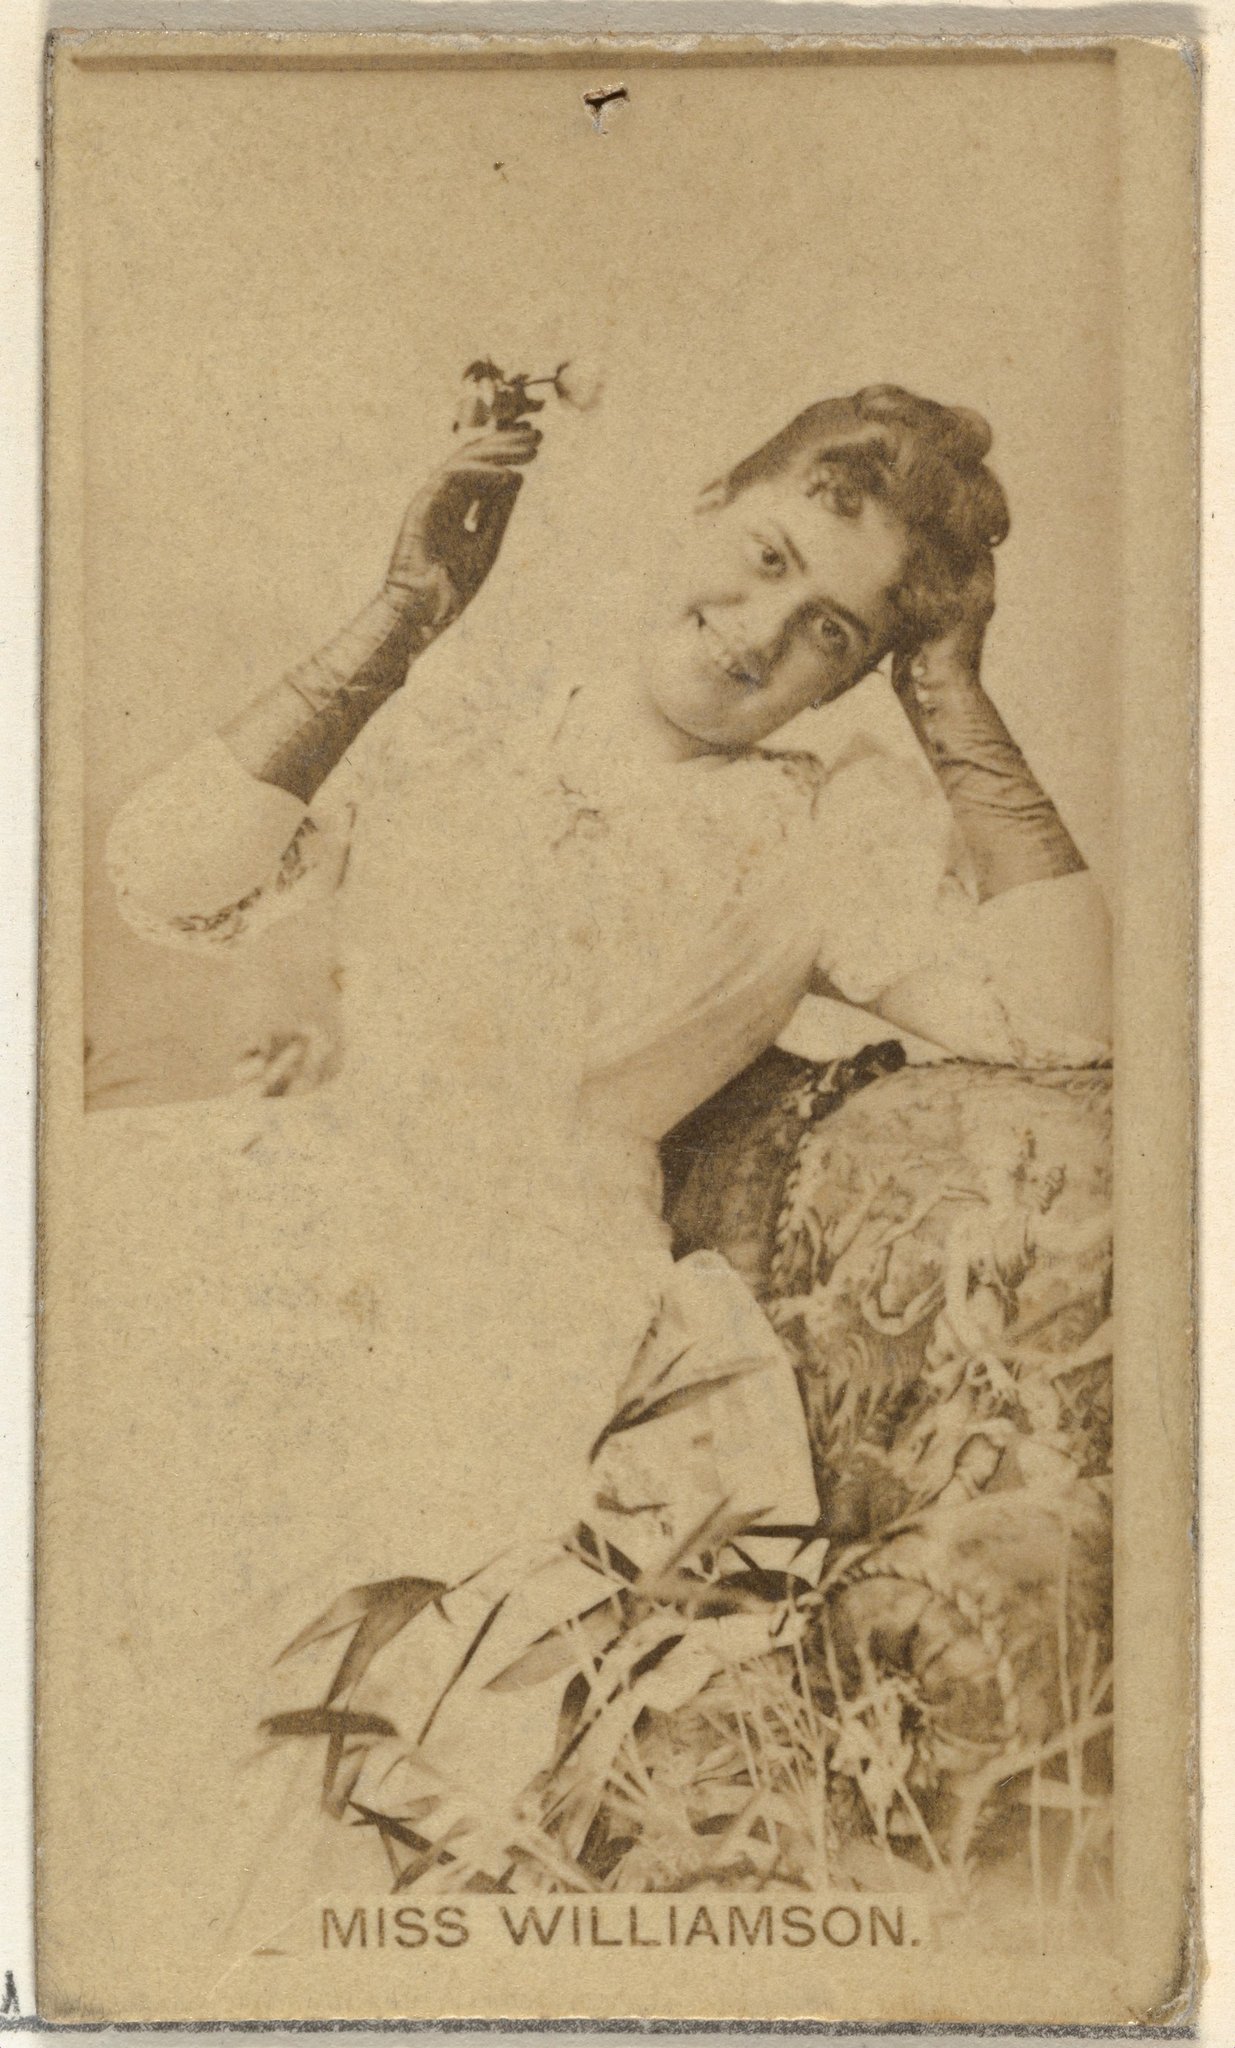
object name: photograph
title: Miss Williamson, from the Actors and Actresses series (N145-8) issued by Duke Sons & Co. to promote Duke Cigarettes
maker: w. duke, sons & co.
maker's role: publisher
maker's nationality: american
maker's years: 1870-1920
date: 1891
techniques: albumen silver print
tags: portraits,women,actresses